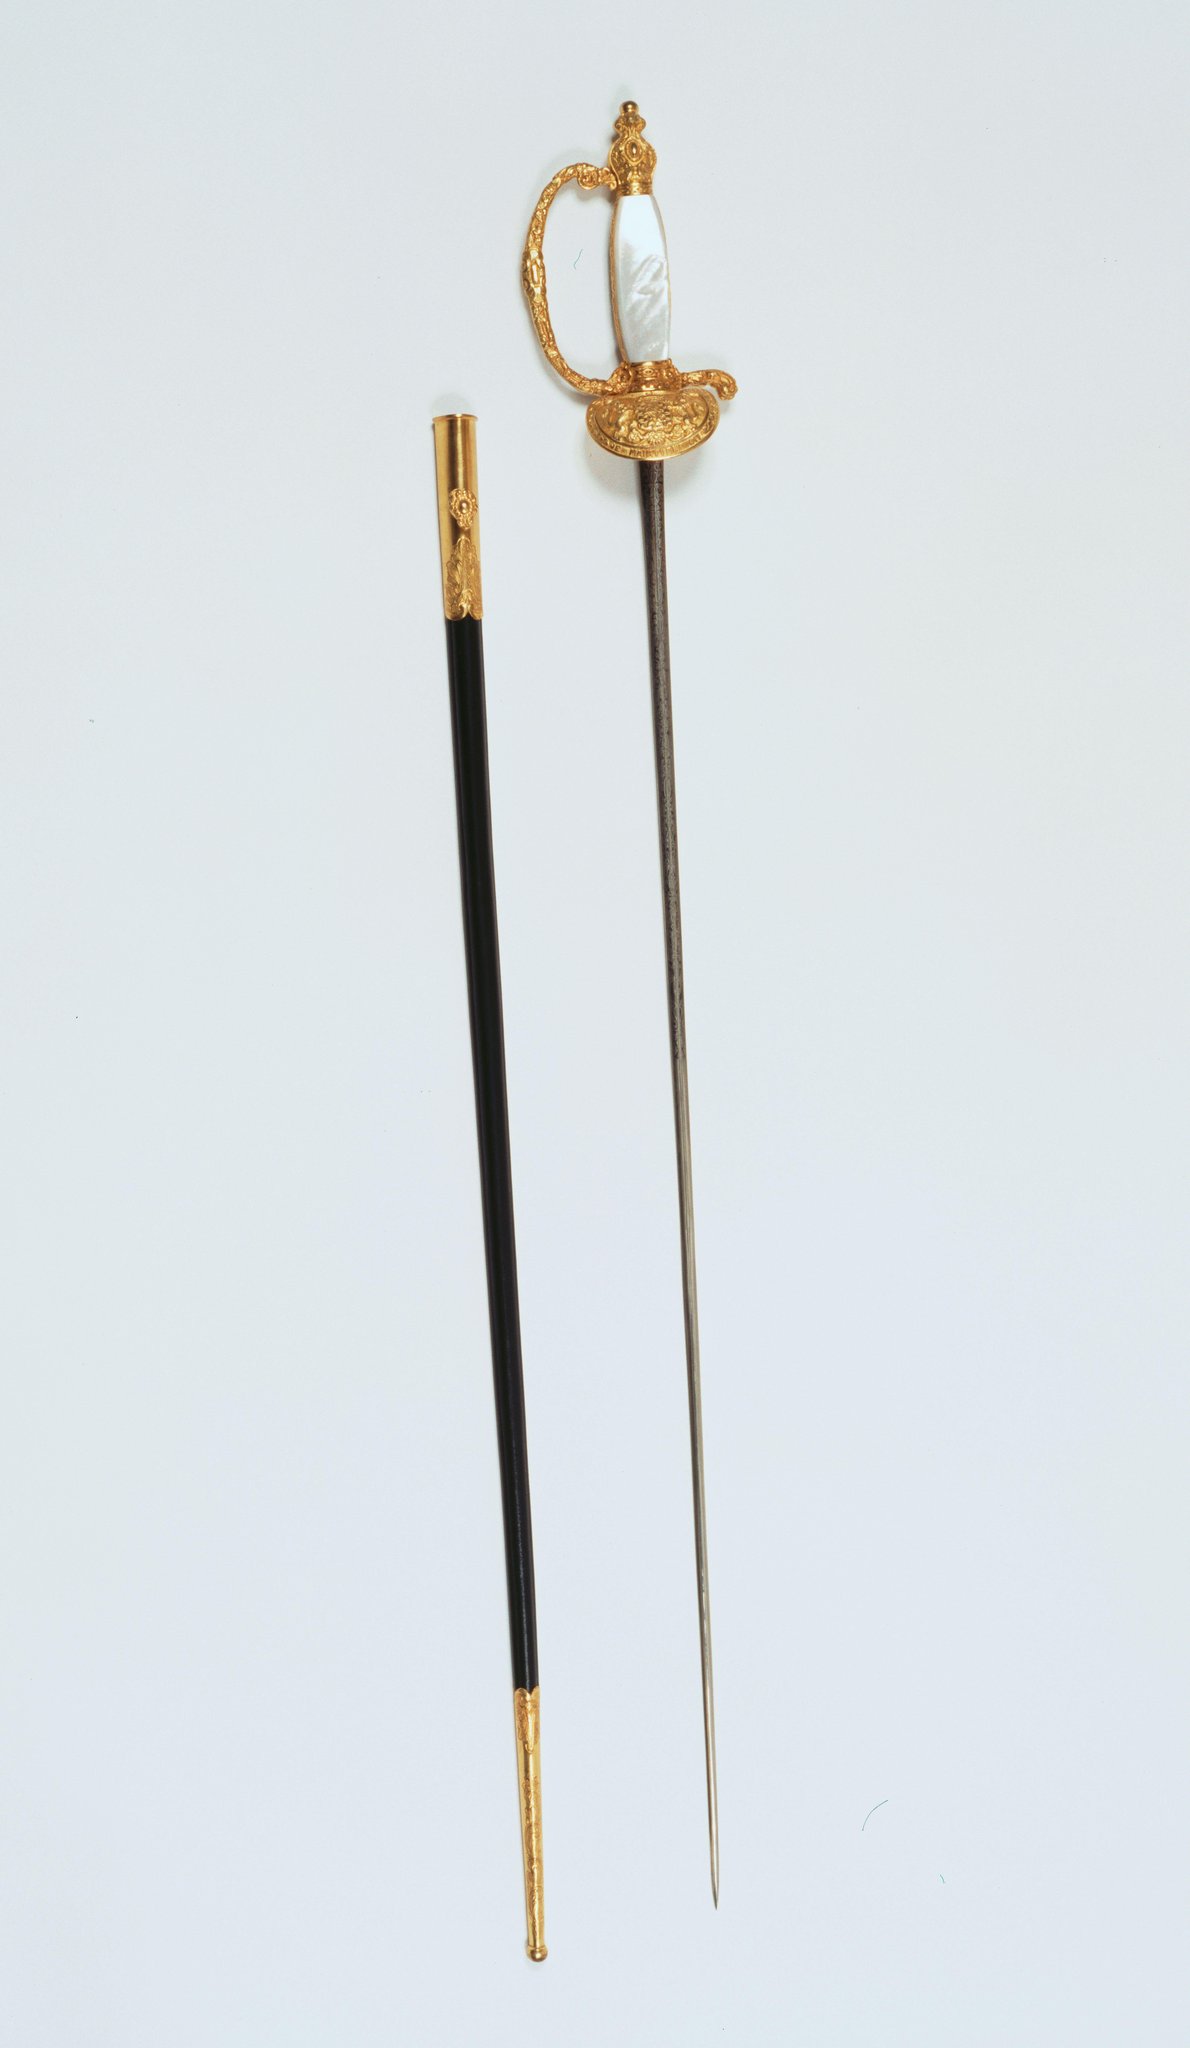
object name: sword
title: Degen van ambassadeur Allard Merens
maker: Anonymous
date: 1875-1950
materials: brass, iron, leather, mother of pearl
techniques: metalworking, engraving, relief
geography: netherlands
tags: the hague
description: Degen met verguld parelmoeren gevest, zwarte (en witte) schede van ambassadeur Allard Merens.